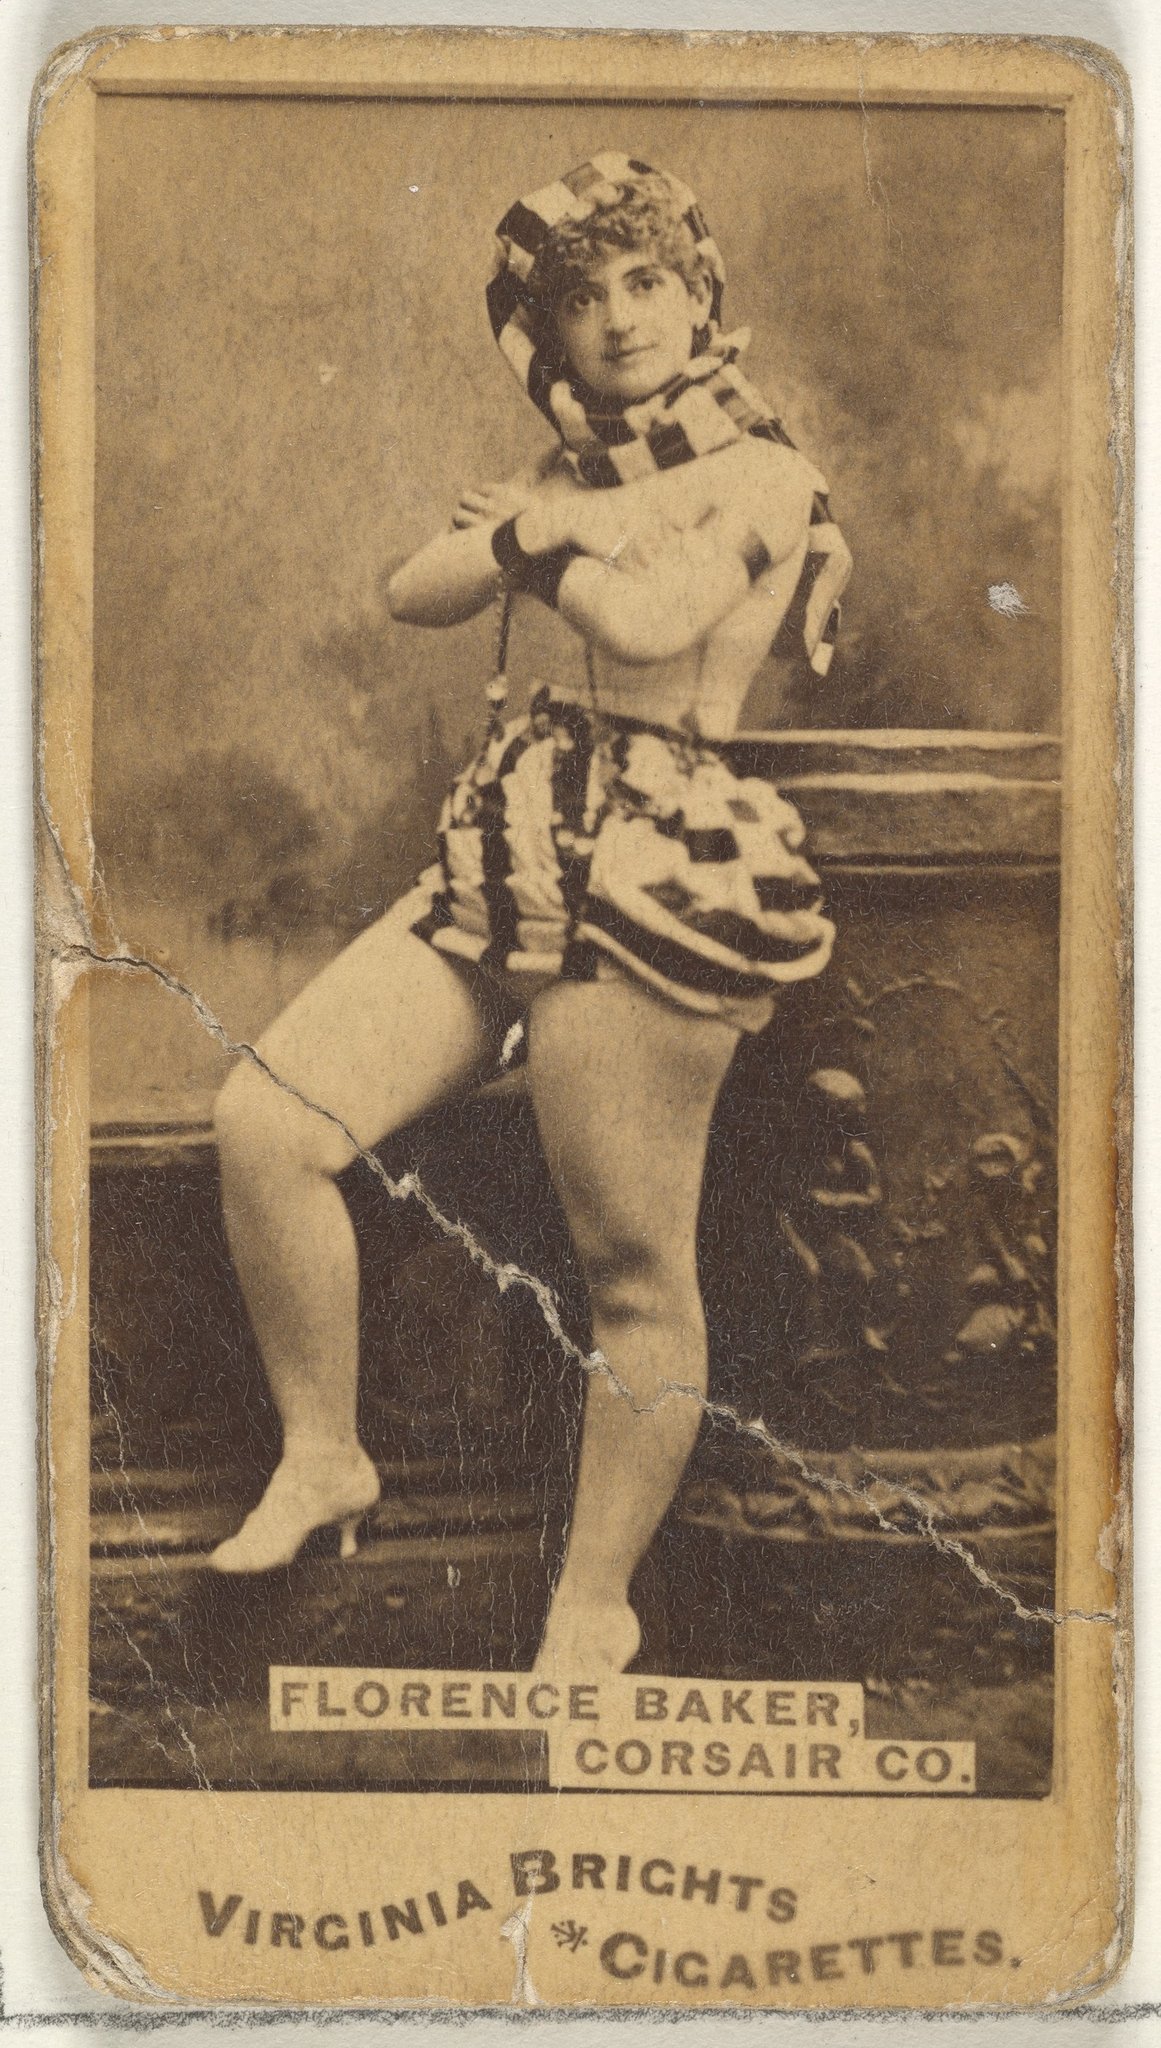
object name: photograph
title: Florence Baker, Corsair Co., from the Actors and Actresses series (N45, Type 1) for Virginia Brights Cigarettes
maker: allen & ginter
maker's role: publisher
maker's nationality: american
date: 1888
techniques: albumen silver print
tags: portraits,women,actresses